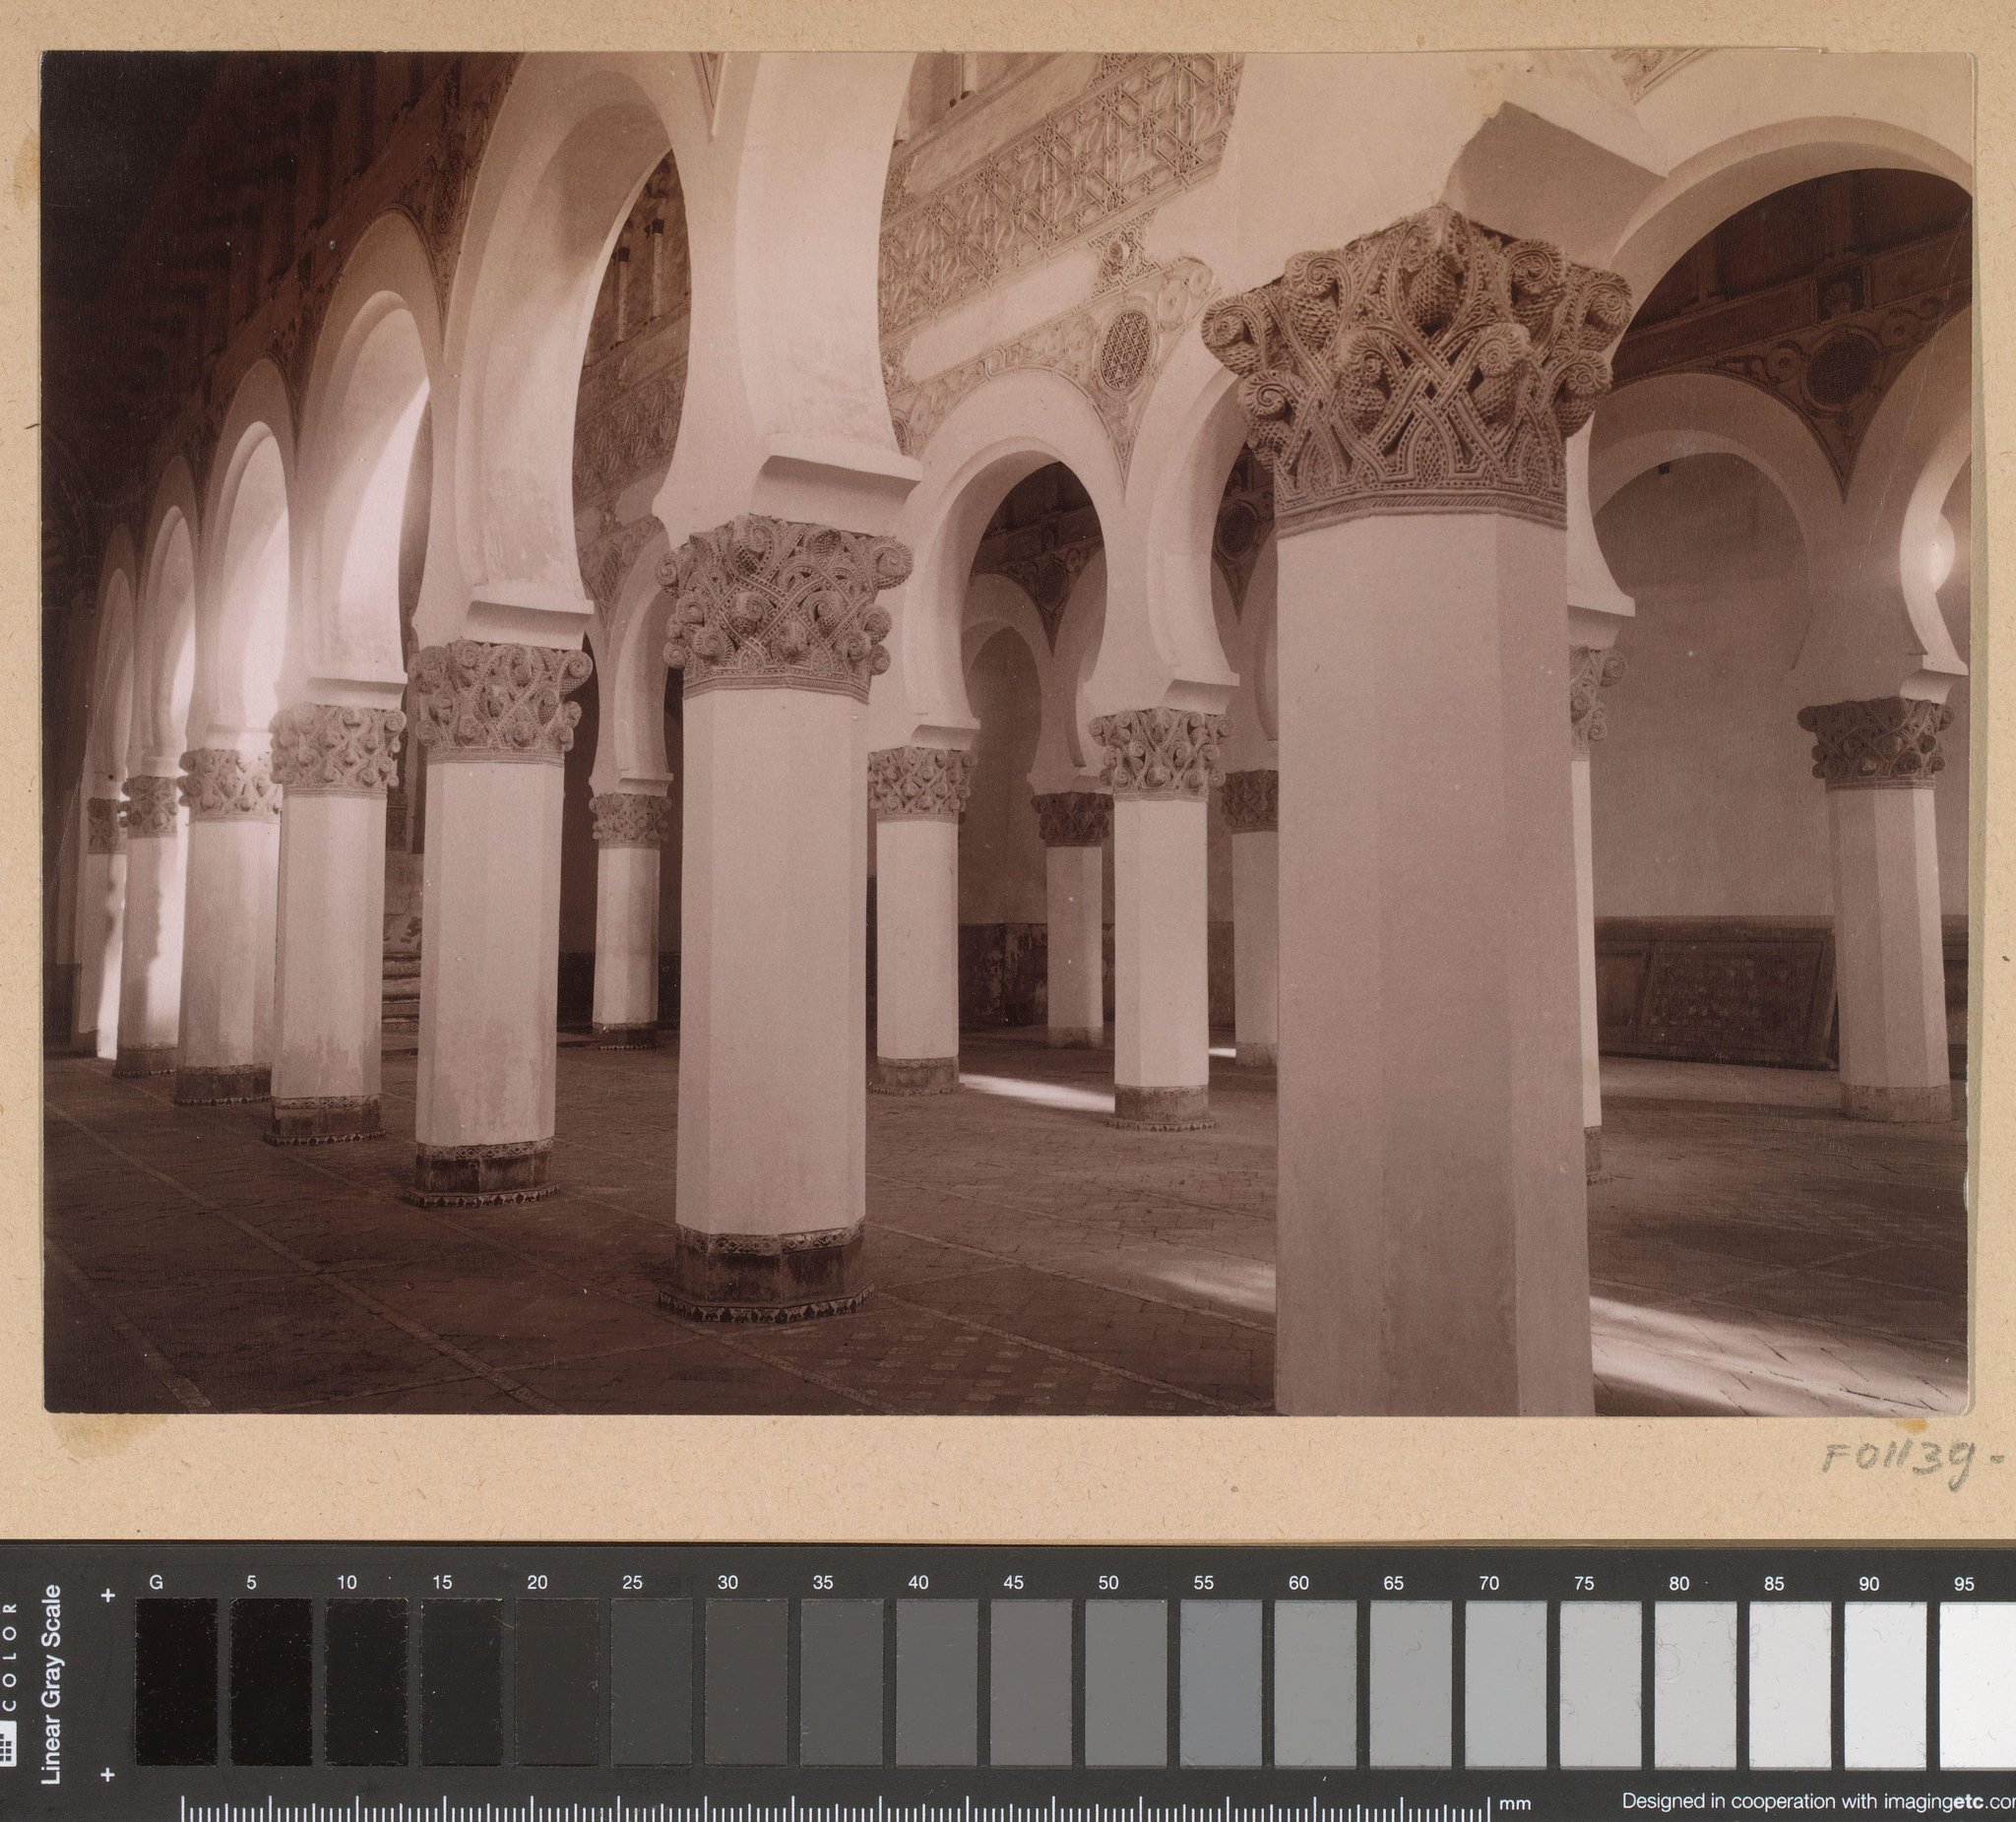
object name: photograph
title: Interieur van de Santa María la Blanca in Toledo, Spanje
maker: Anonymous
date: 1851-1890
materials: paper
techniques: albumen print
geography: toledo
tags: interior of church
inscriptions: inscription: ‘Sta Maria la Blanca/ Antigua sinagoga’